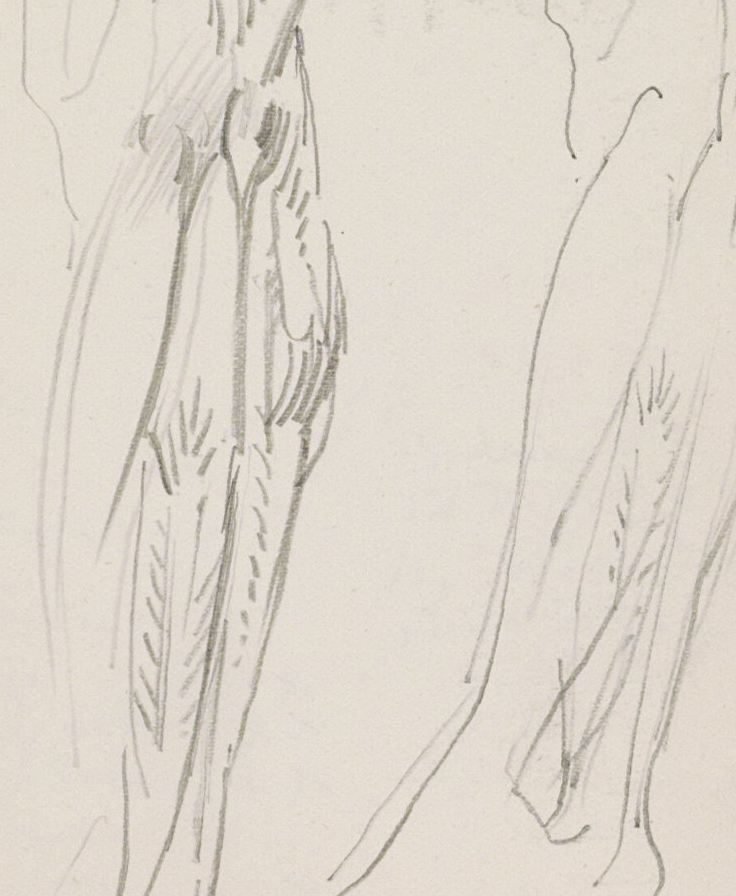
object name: sketchbook leaf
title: Spieren in het onderbeen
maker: reijer stolk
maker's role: draughtsman, print maker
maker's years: 1896-1945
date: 1906-1945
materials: paper, pencil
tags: lower leg, muscles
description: Blad 6 recto uit een schetsboek met 42 bladen.